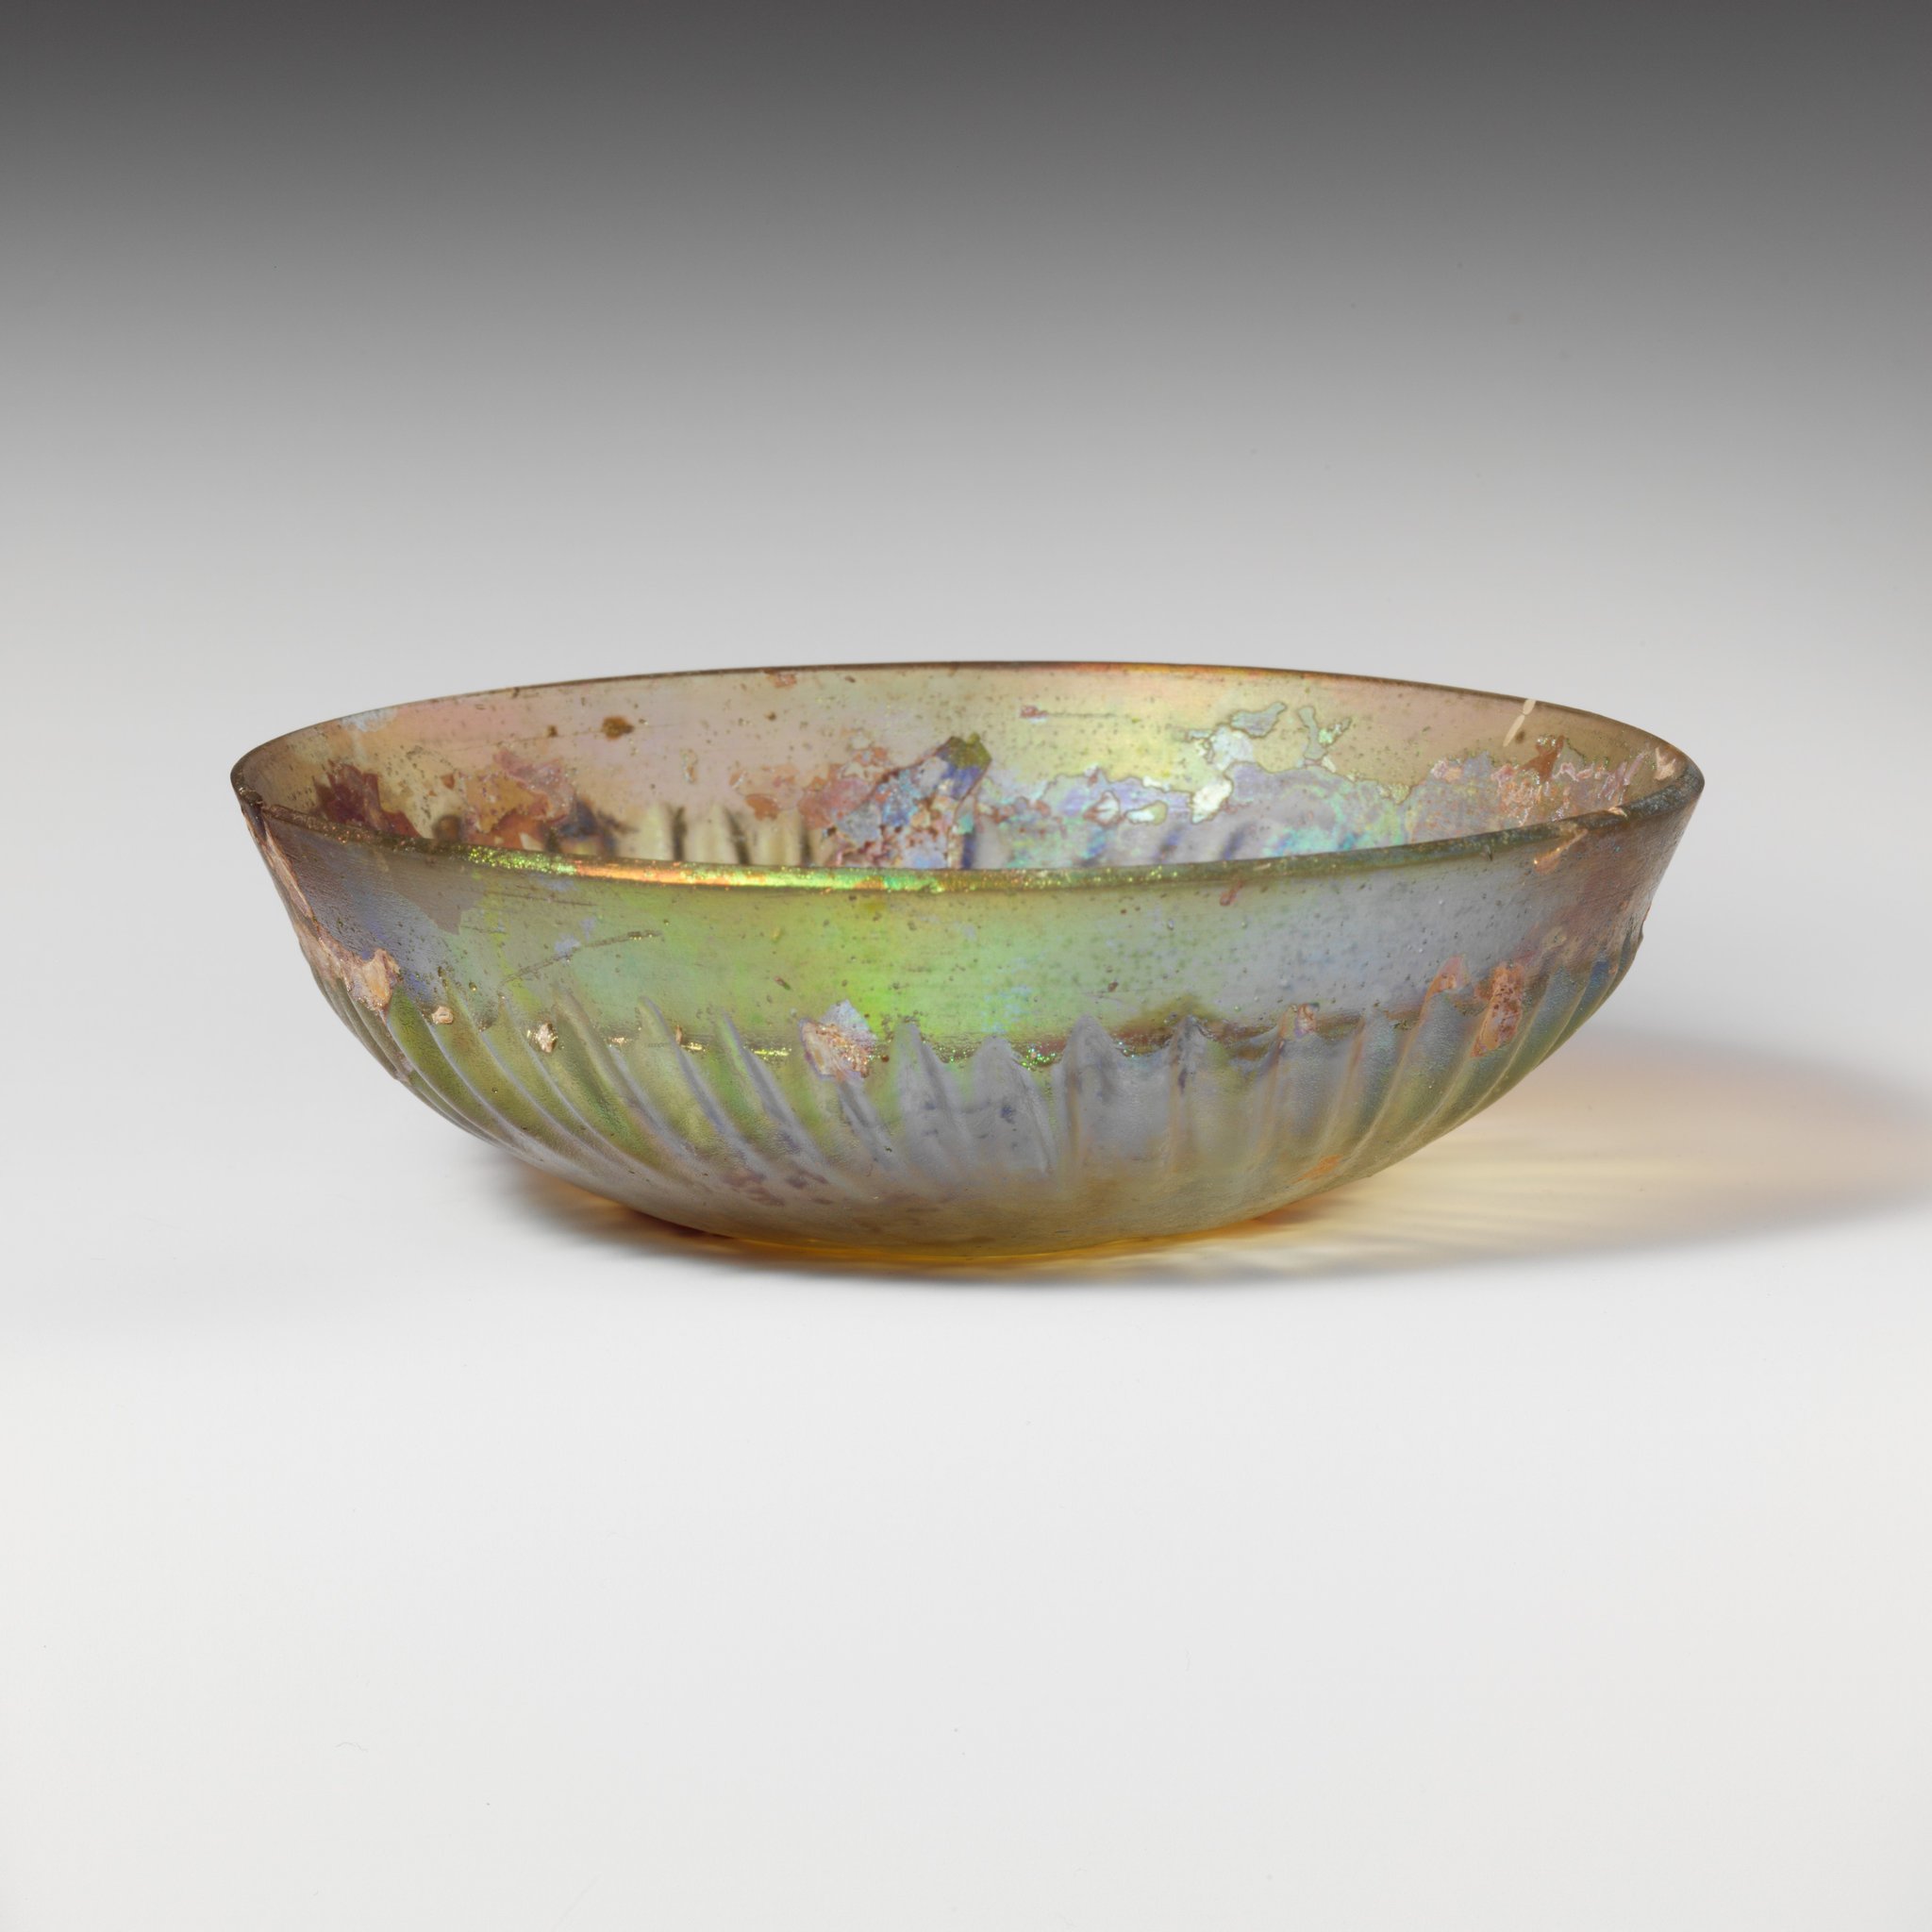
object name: bowl, ribbed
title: Glass ribbed bowl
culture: roman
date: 34 BCE-66 CE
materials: glass